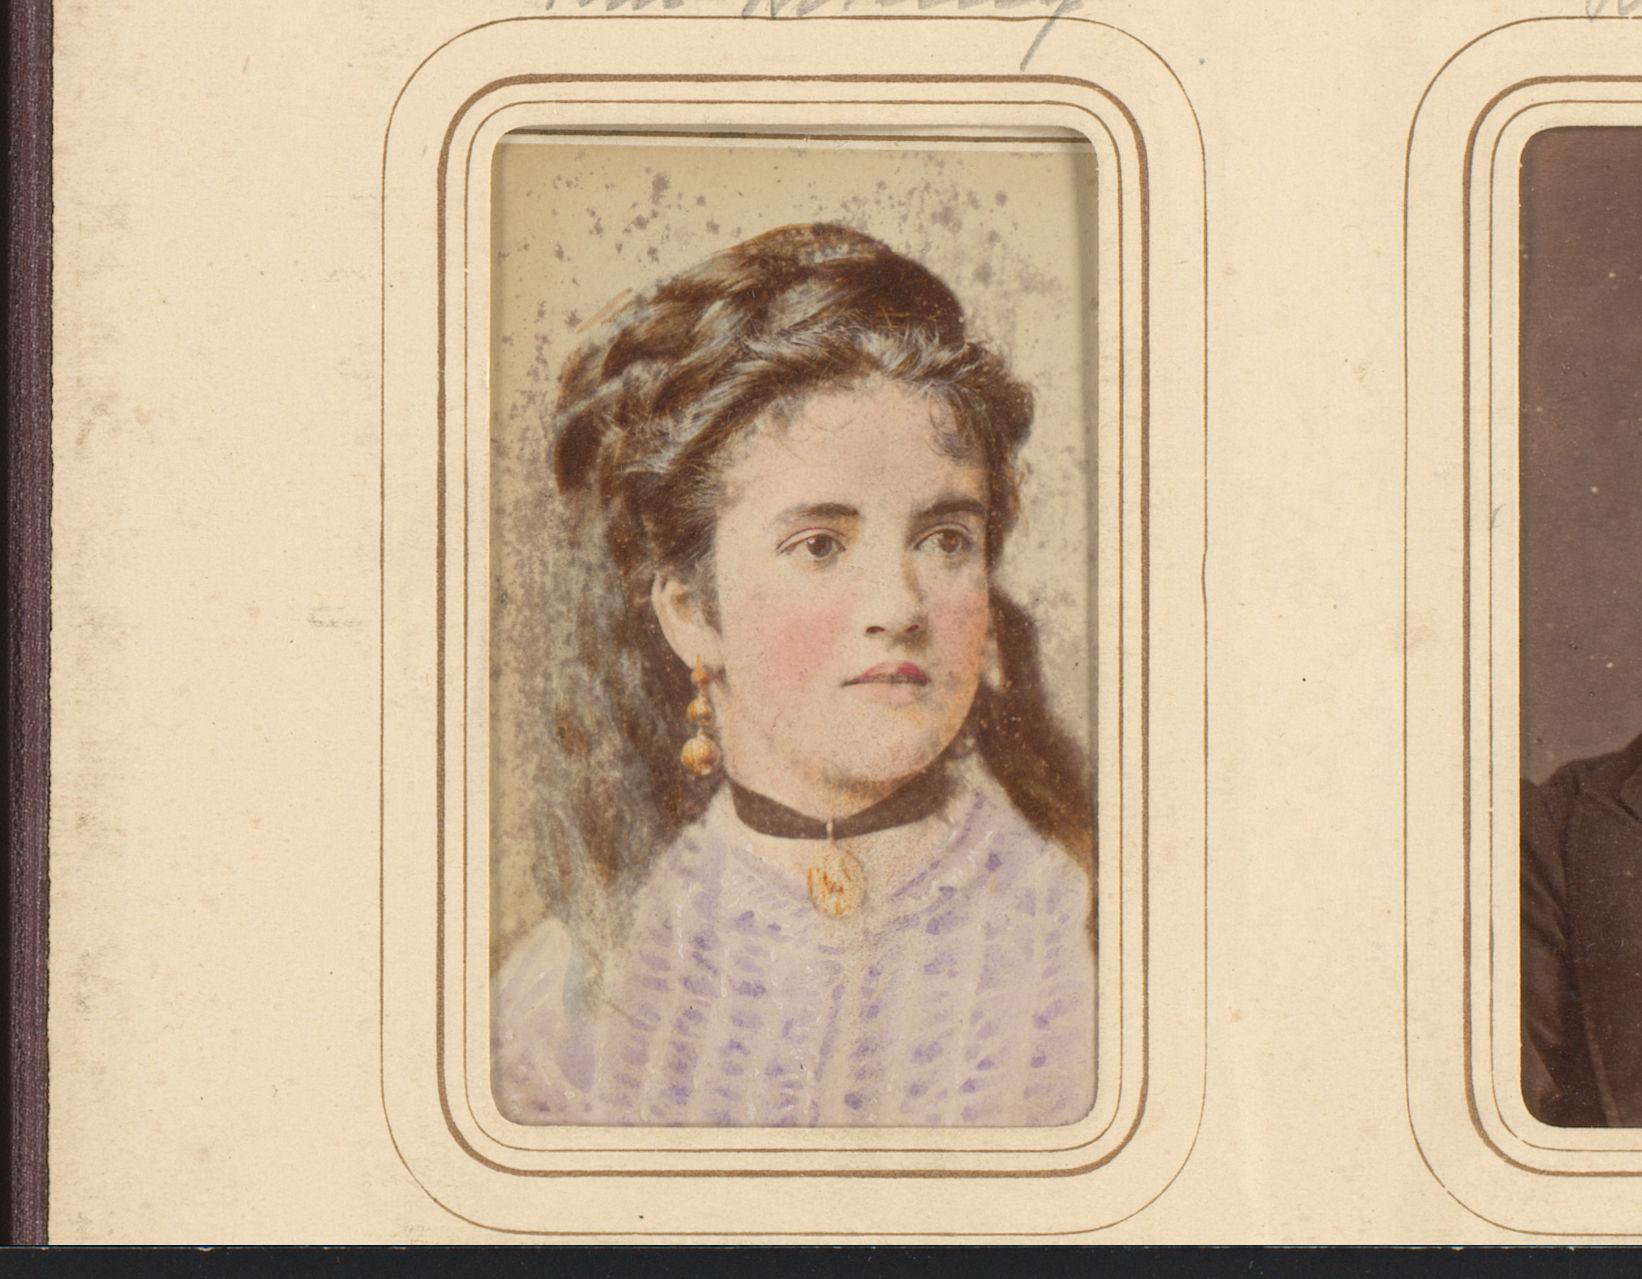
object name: album leaf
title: Portret van Toni Kitzing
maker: sophus williams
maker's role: publisher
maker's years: 1835-1900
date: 1867-1880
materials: cardboard, photographic support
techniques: albumen print, hand coloring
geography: berlin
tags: adult woman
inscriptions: name: ‘Phot. Loescher & Petsch’, annotation: ‘Toni Kitzing’, inscription: ‘Loescher & Petsch [...] Berlin / Atelier: / Leipziger-Strasse 132, / Eingang / im / Mittel-Portal.’, name: ‘Sophus Williams, Berlin.’